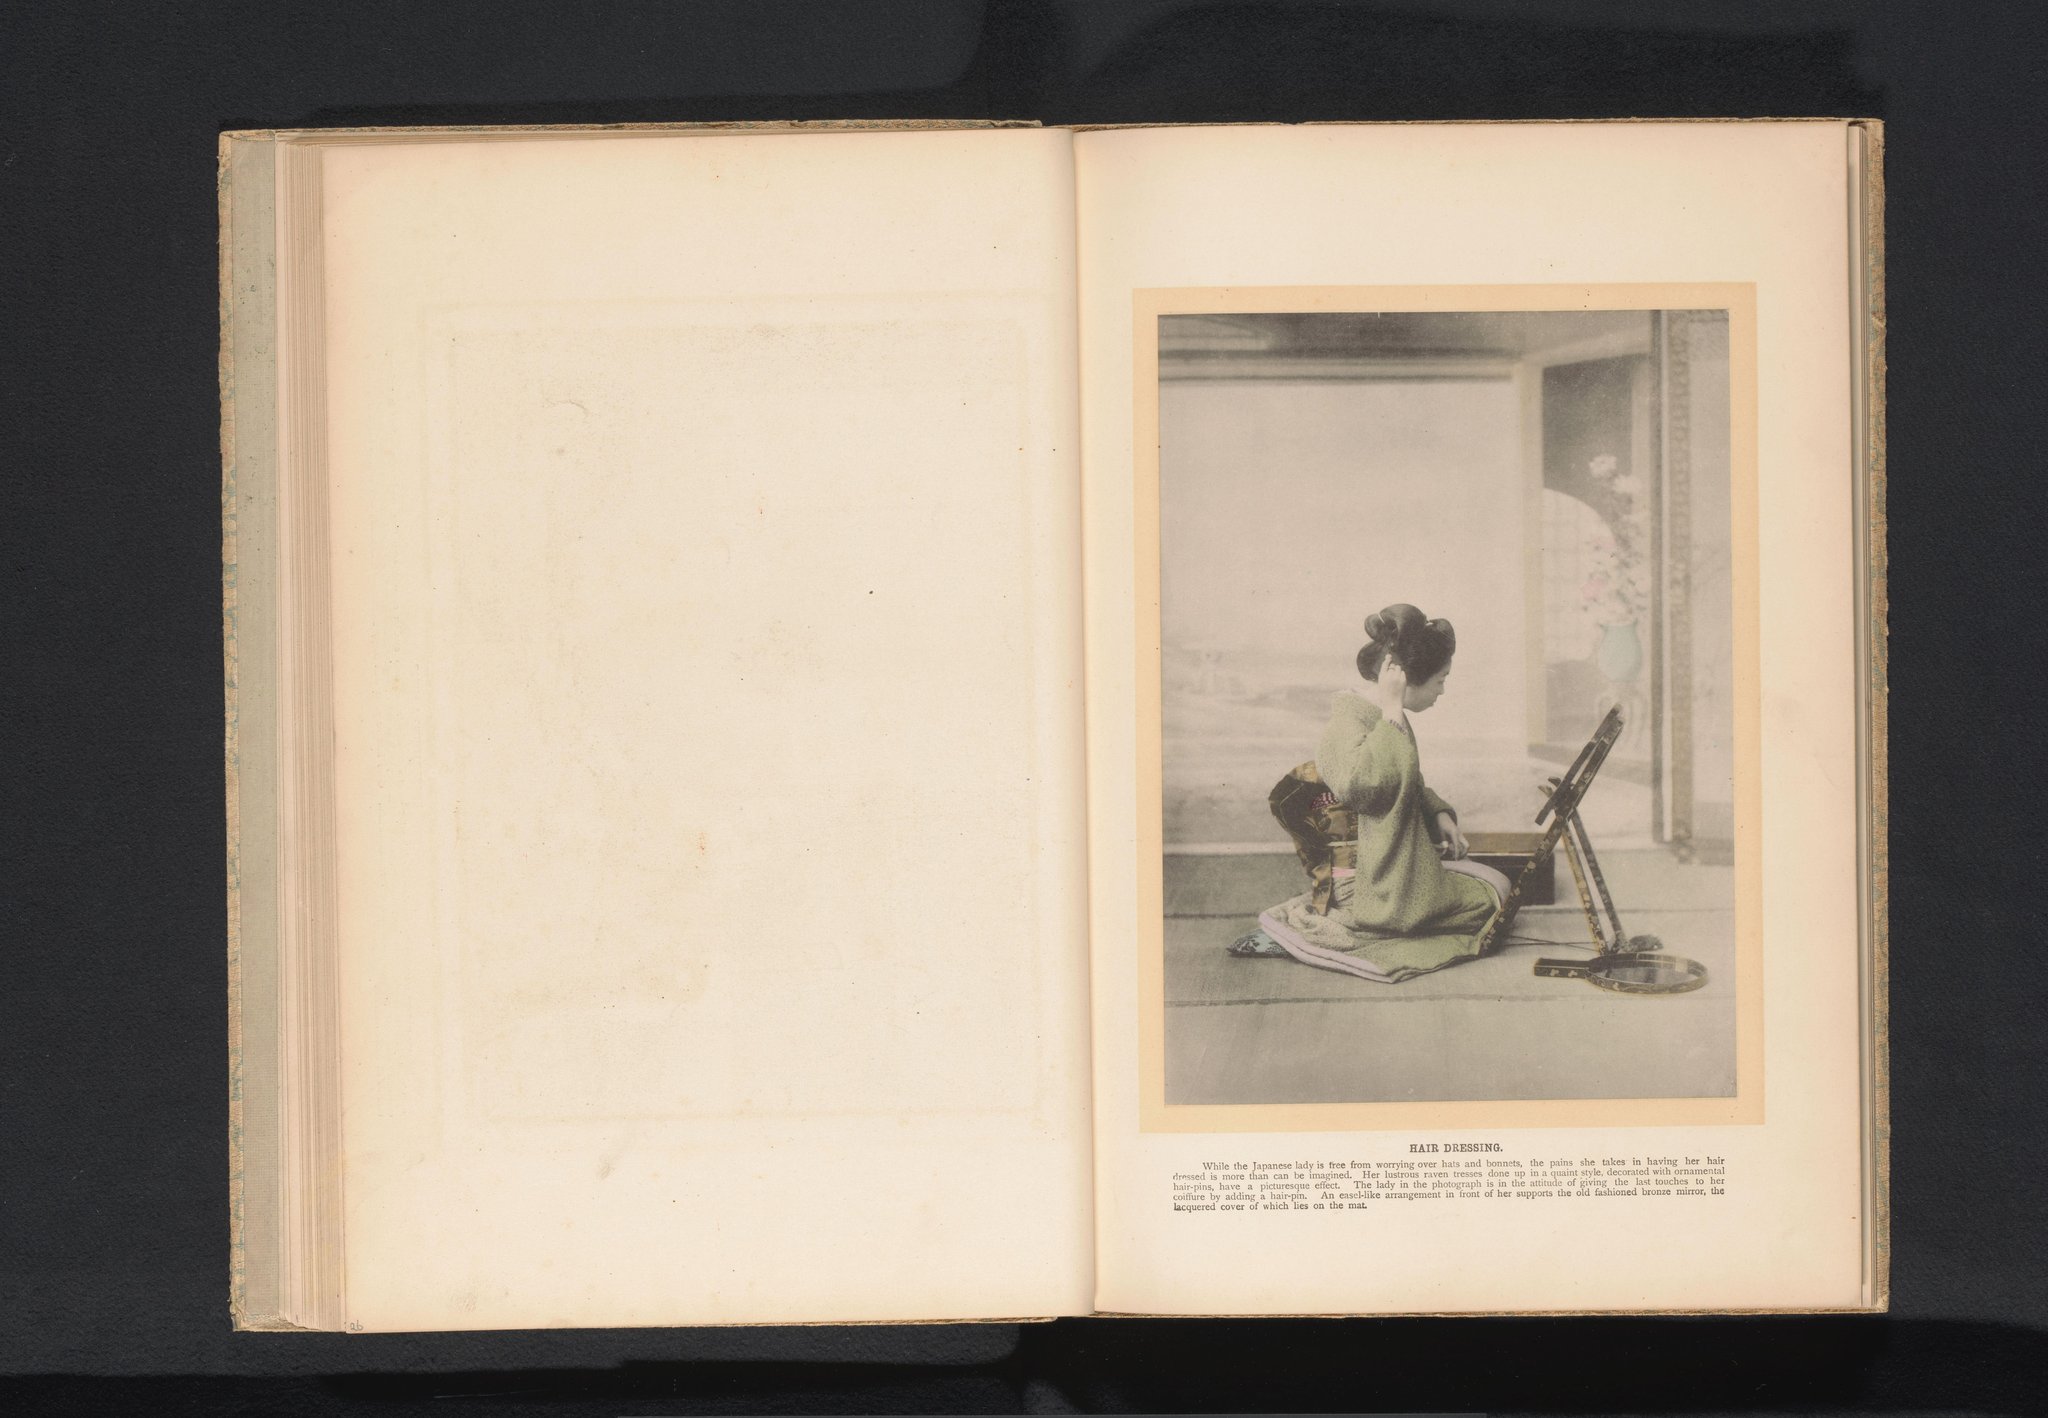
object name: page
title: Hair Dressing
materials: paper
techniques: photograph, lithograph, hand coloring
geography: tokyo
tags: hairdress - aa - ~ women, japan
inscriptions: inscription: ‘While the (...) the mat.’